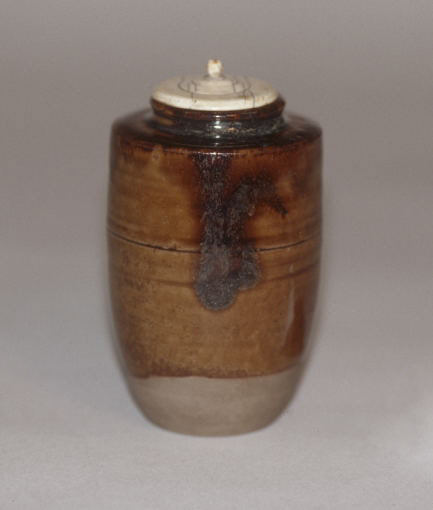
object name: tea jar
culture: japanese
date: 1701-1800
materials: glaze, paste